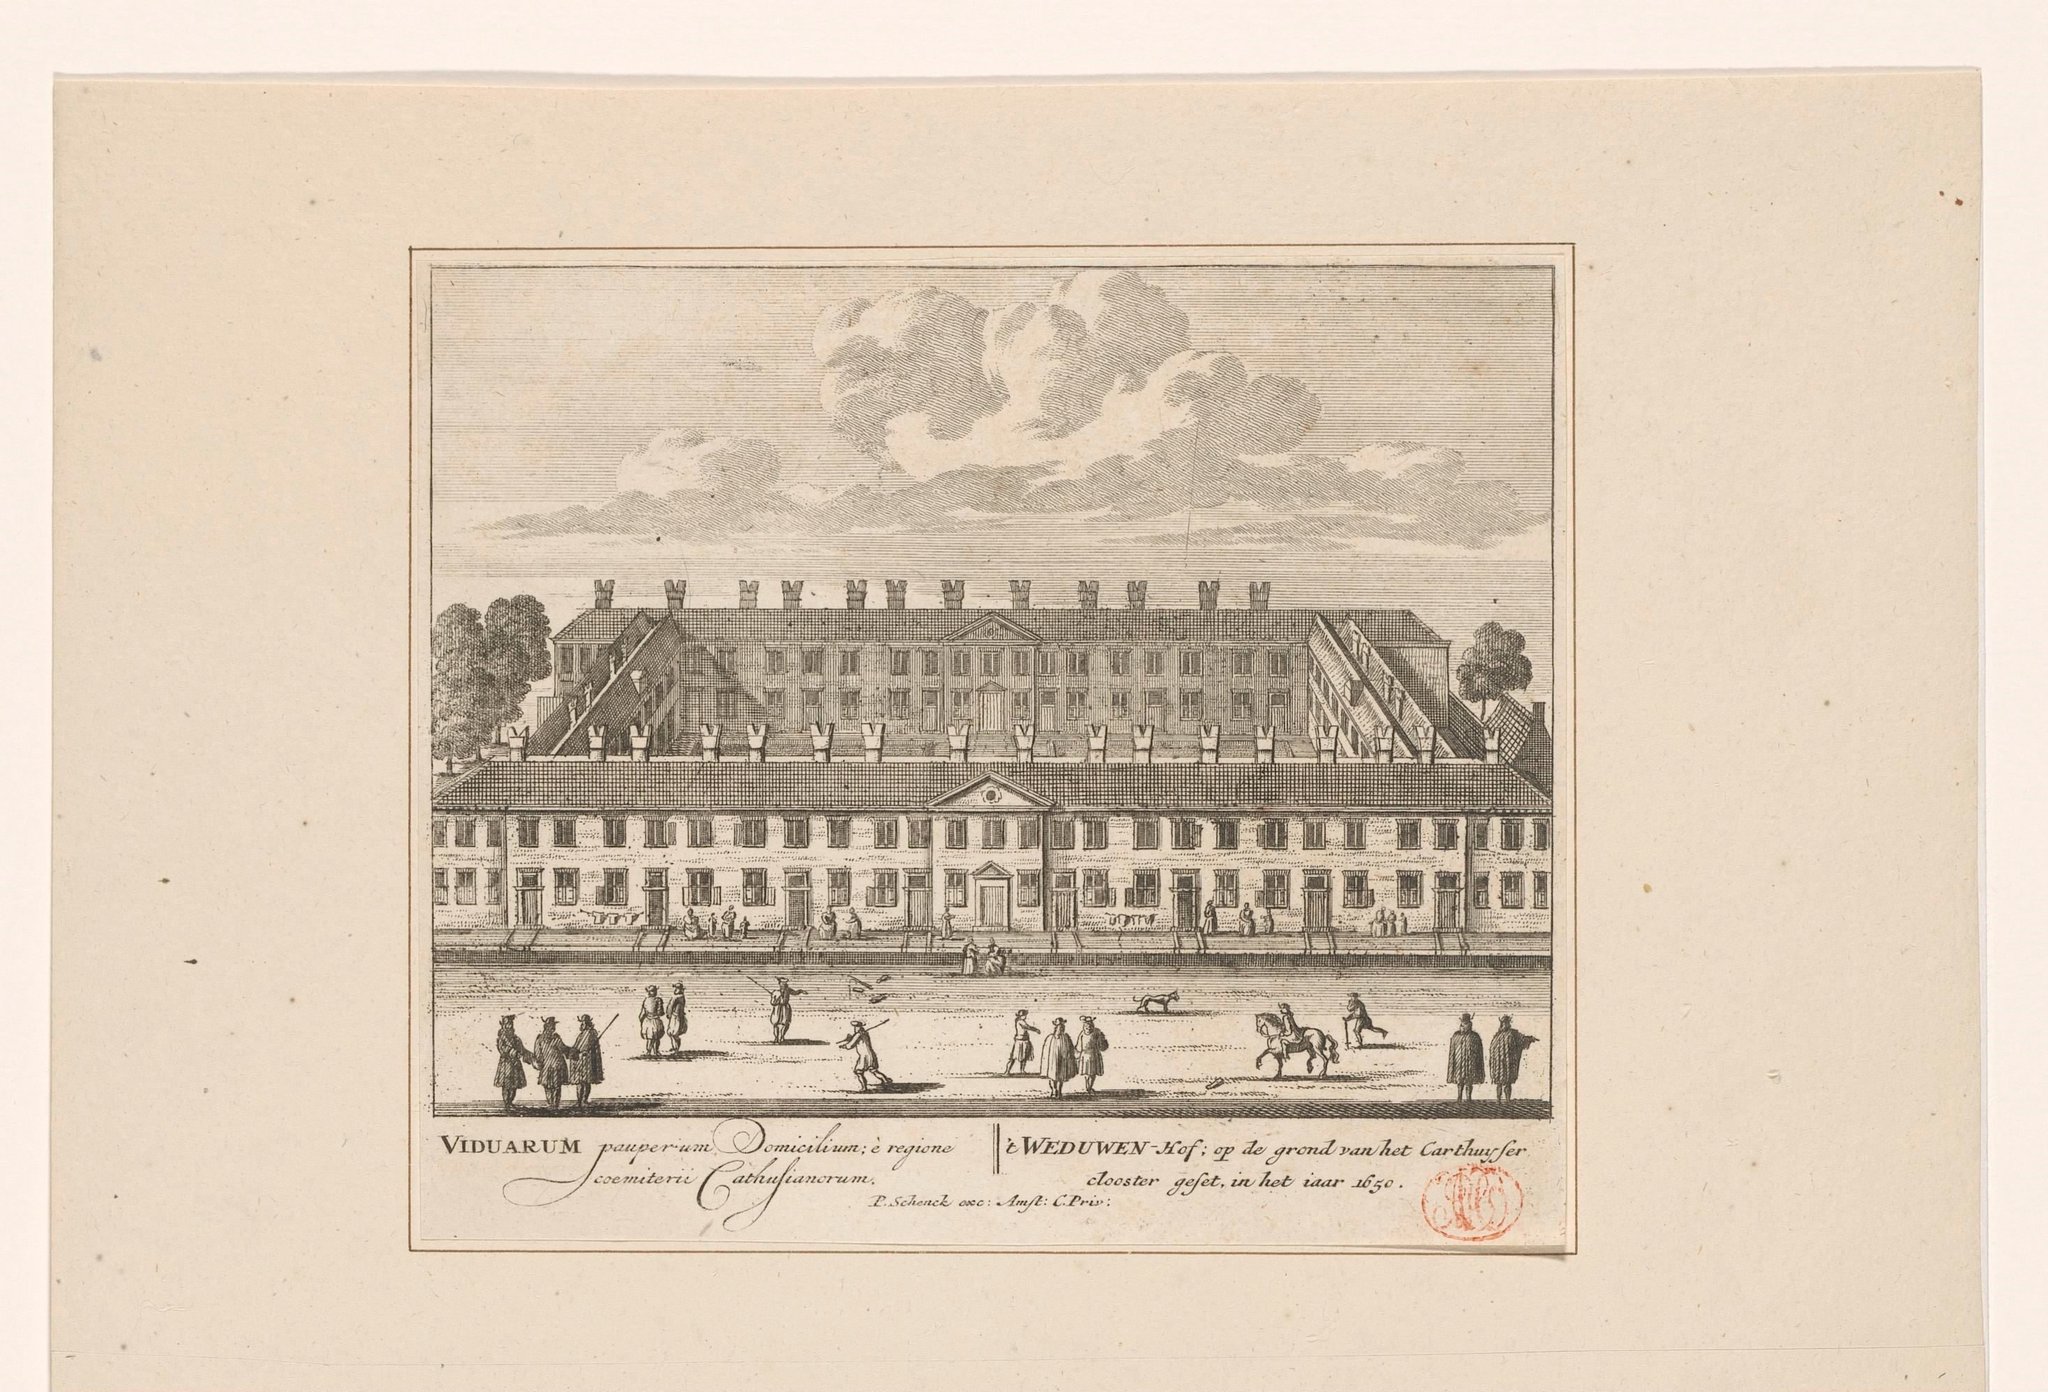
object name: print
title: 100 Afbeeldinge der voornaamste gebouwen van Amsterdam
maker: Anonymous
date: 1710-1711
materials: paper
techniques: engraving, etching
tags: public welfare, poorhouse, old-people's home, street (+ city(-scape) with figures, staffage)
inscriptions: collector's mark: Lugt 195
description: Genummerde staat van prent ook gebruikt in: 100 Afbeeldinge der voornaamste gebouwen van Amsterdam. Amsterdam, Pieter Schenk (I), s.a. [1710-1711]. En in: 100 Afbeeldinge der voornaamste gebouwen van Amsterdam. Amsterdam, Barent Greve, s.a. [1757-1766].* *In de tweede uitgave, uitgegeven door Barent Greve, is alleen de titelprent aangepast. De overige prenten zijn onveranderd gebleven.